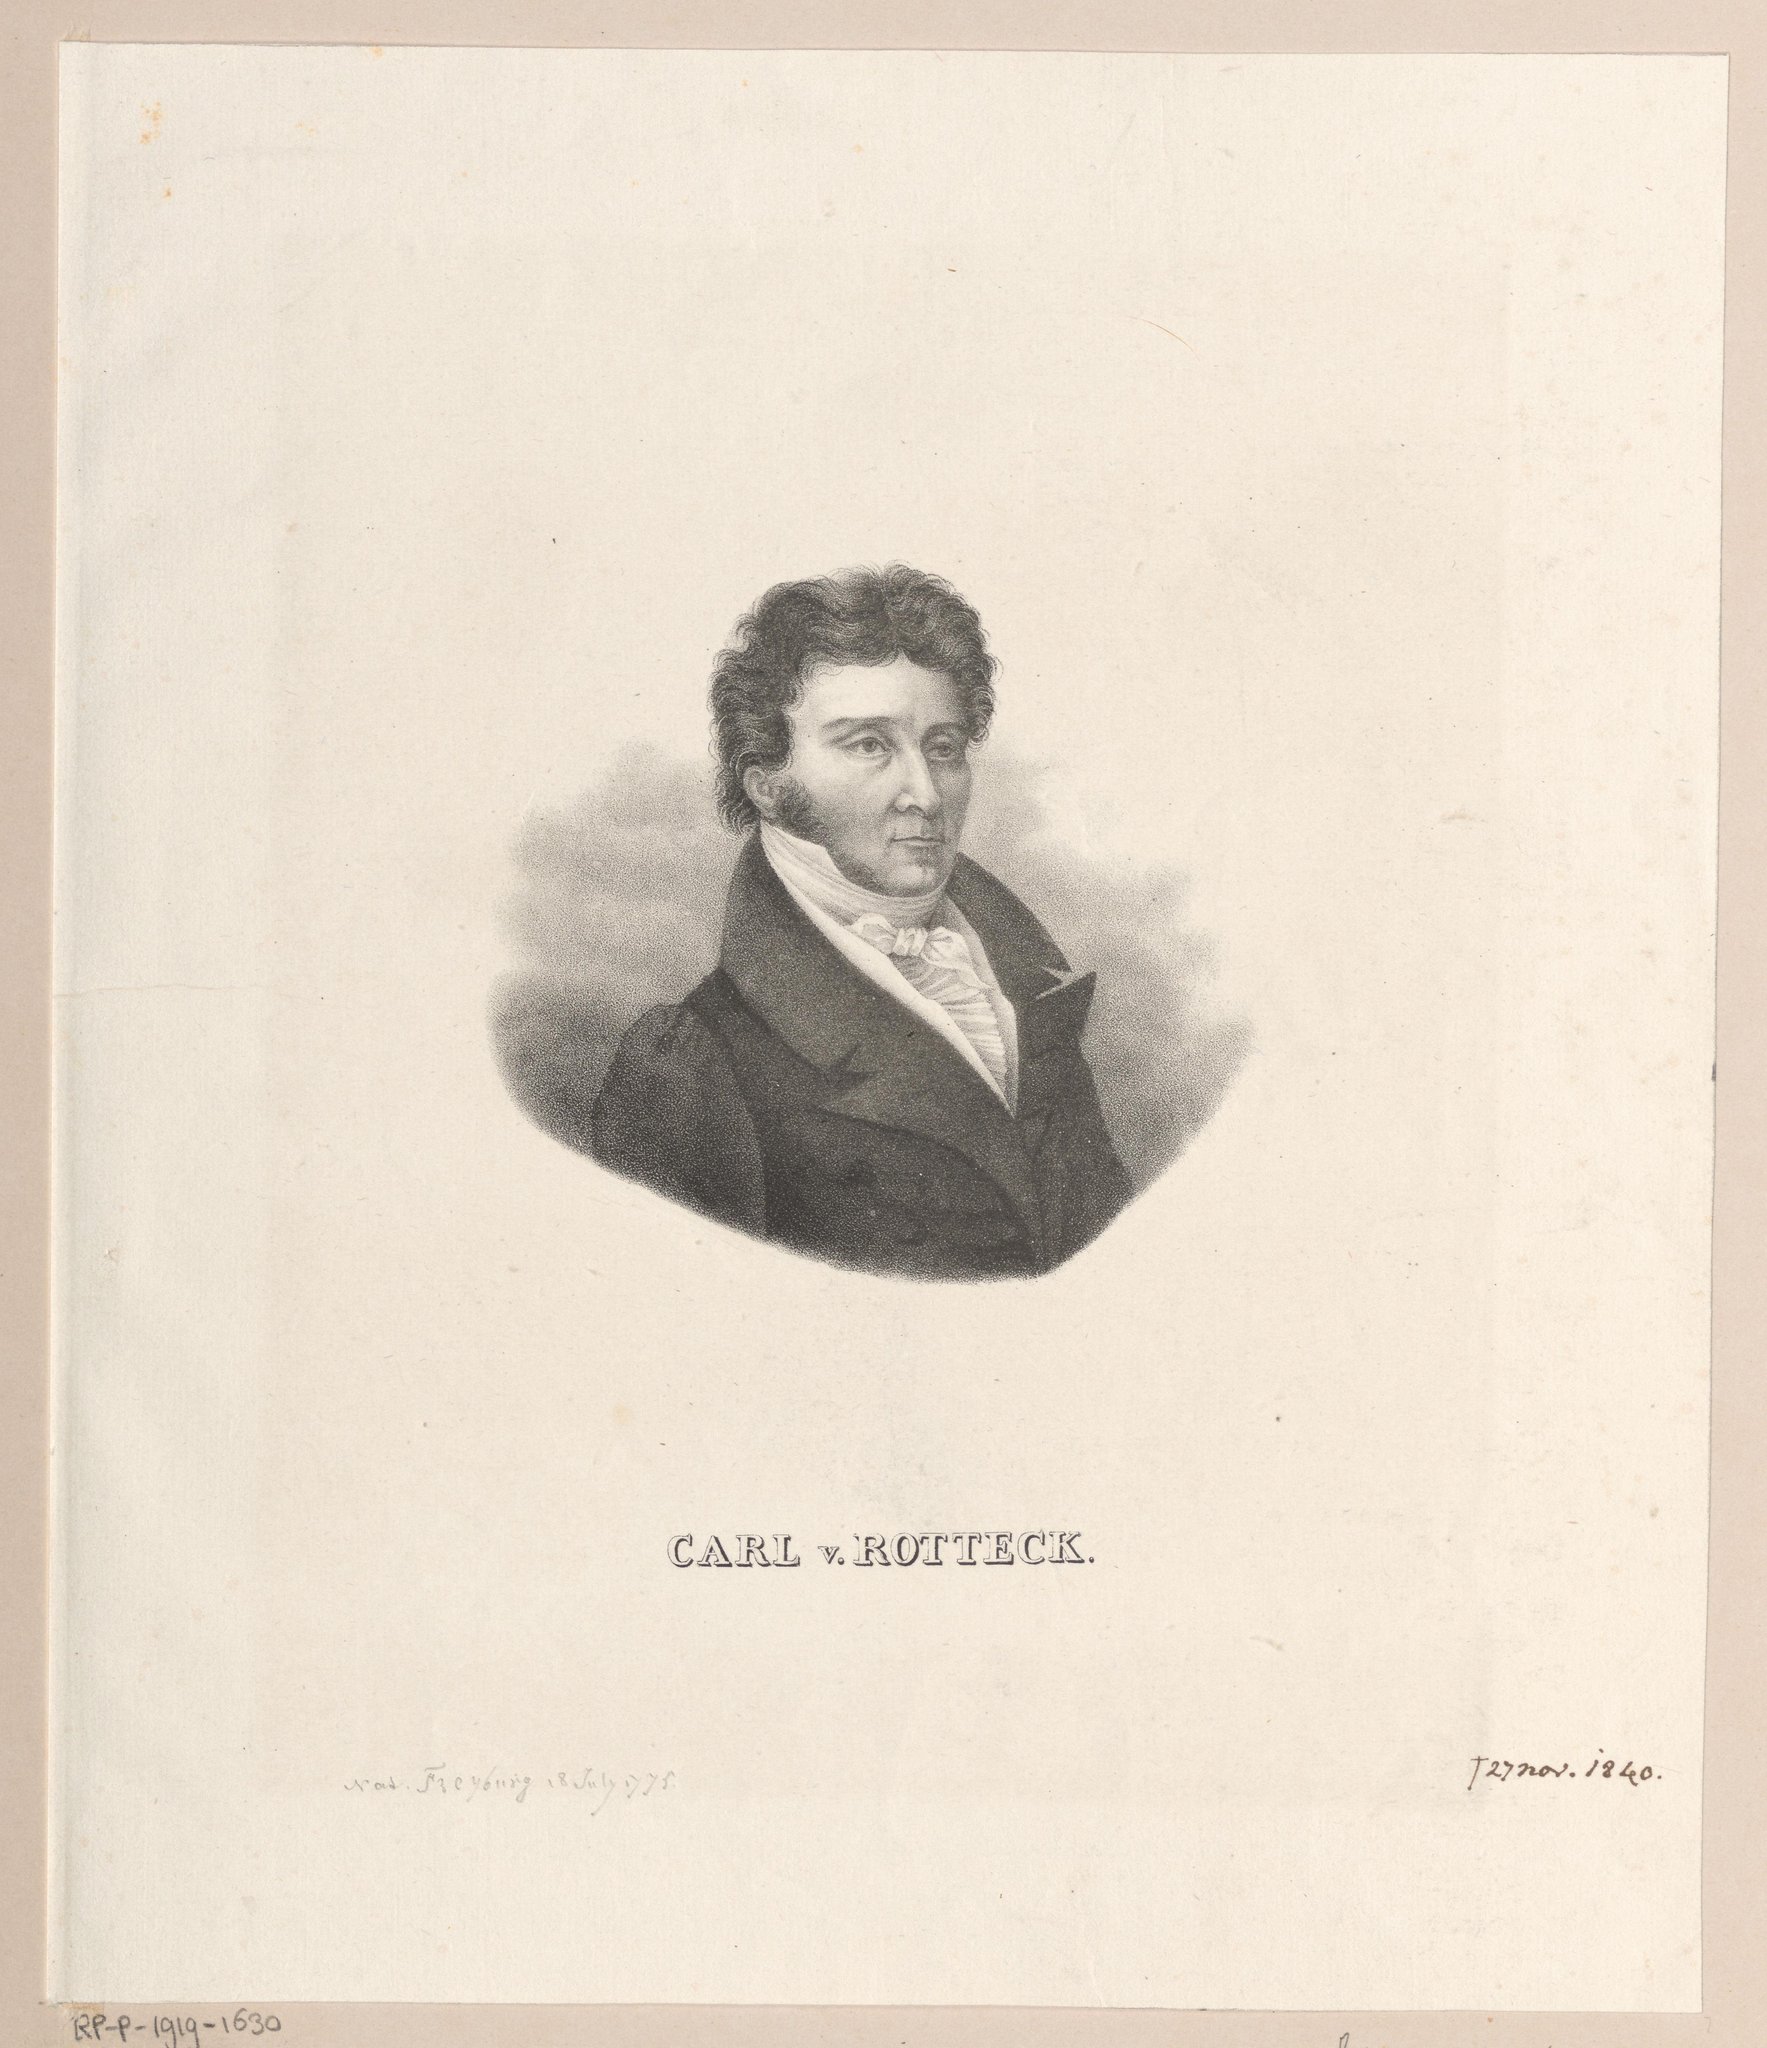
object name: print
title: Portret van Karl von Rotteck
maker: Anonymous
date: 1800-1849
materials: paper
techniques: lithograph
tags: historical persons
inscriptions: collector's mark: Lugt 2228